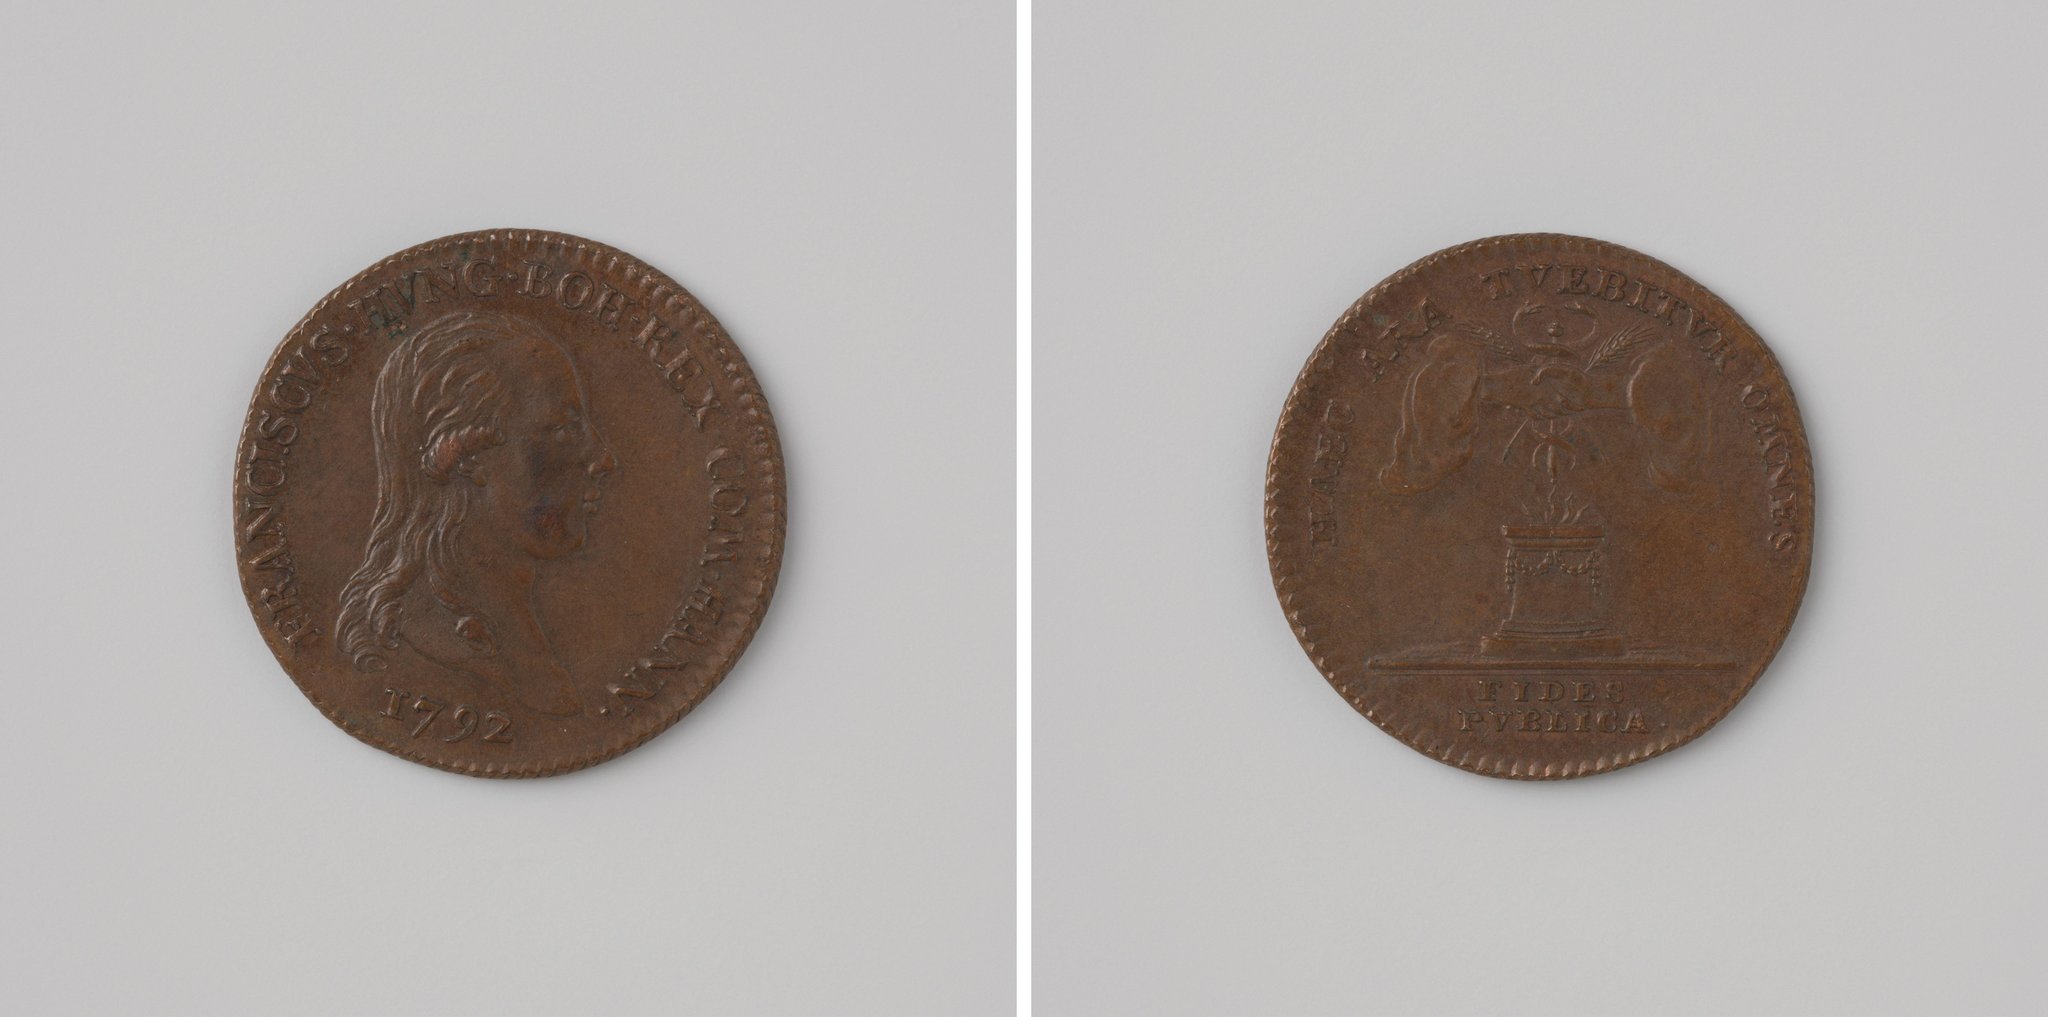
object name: history medal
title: Inhuldiging van Frans II, Duits keizer als graaf van Henegouwen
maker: Anonymous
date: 1792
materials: bronze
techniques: striking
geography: brussels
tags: vienna, frans ii (rooms-duits keizer)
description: Bronzen penning. Voorzijde: borststuk man binnen omschrift. Keerzijde: twee ineen geslagen handen uit wolken voor Mercuriusstaf tussen twee korenaren boven brandend altaar binnen omschrift; afsnede: opschrift